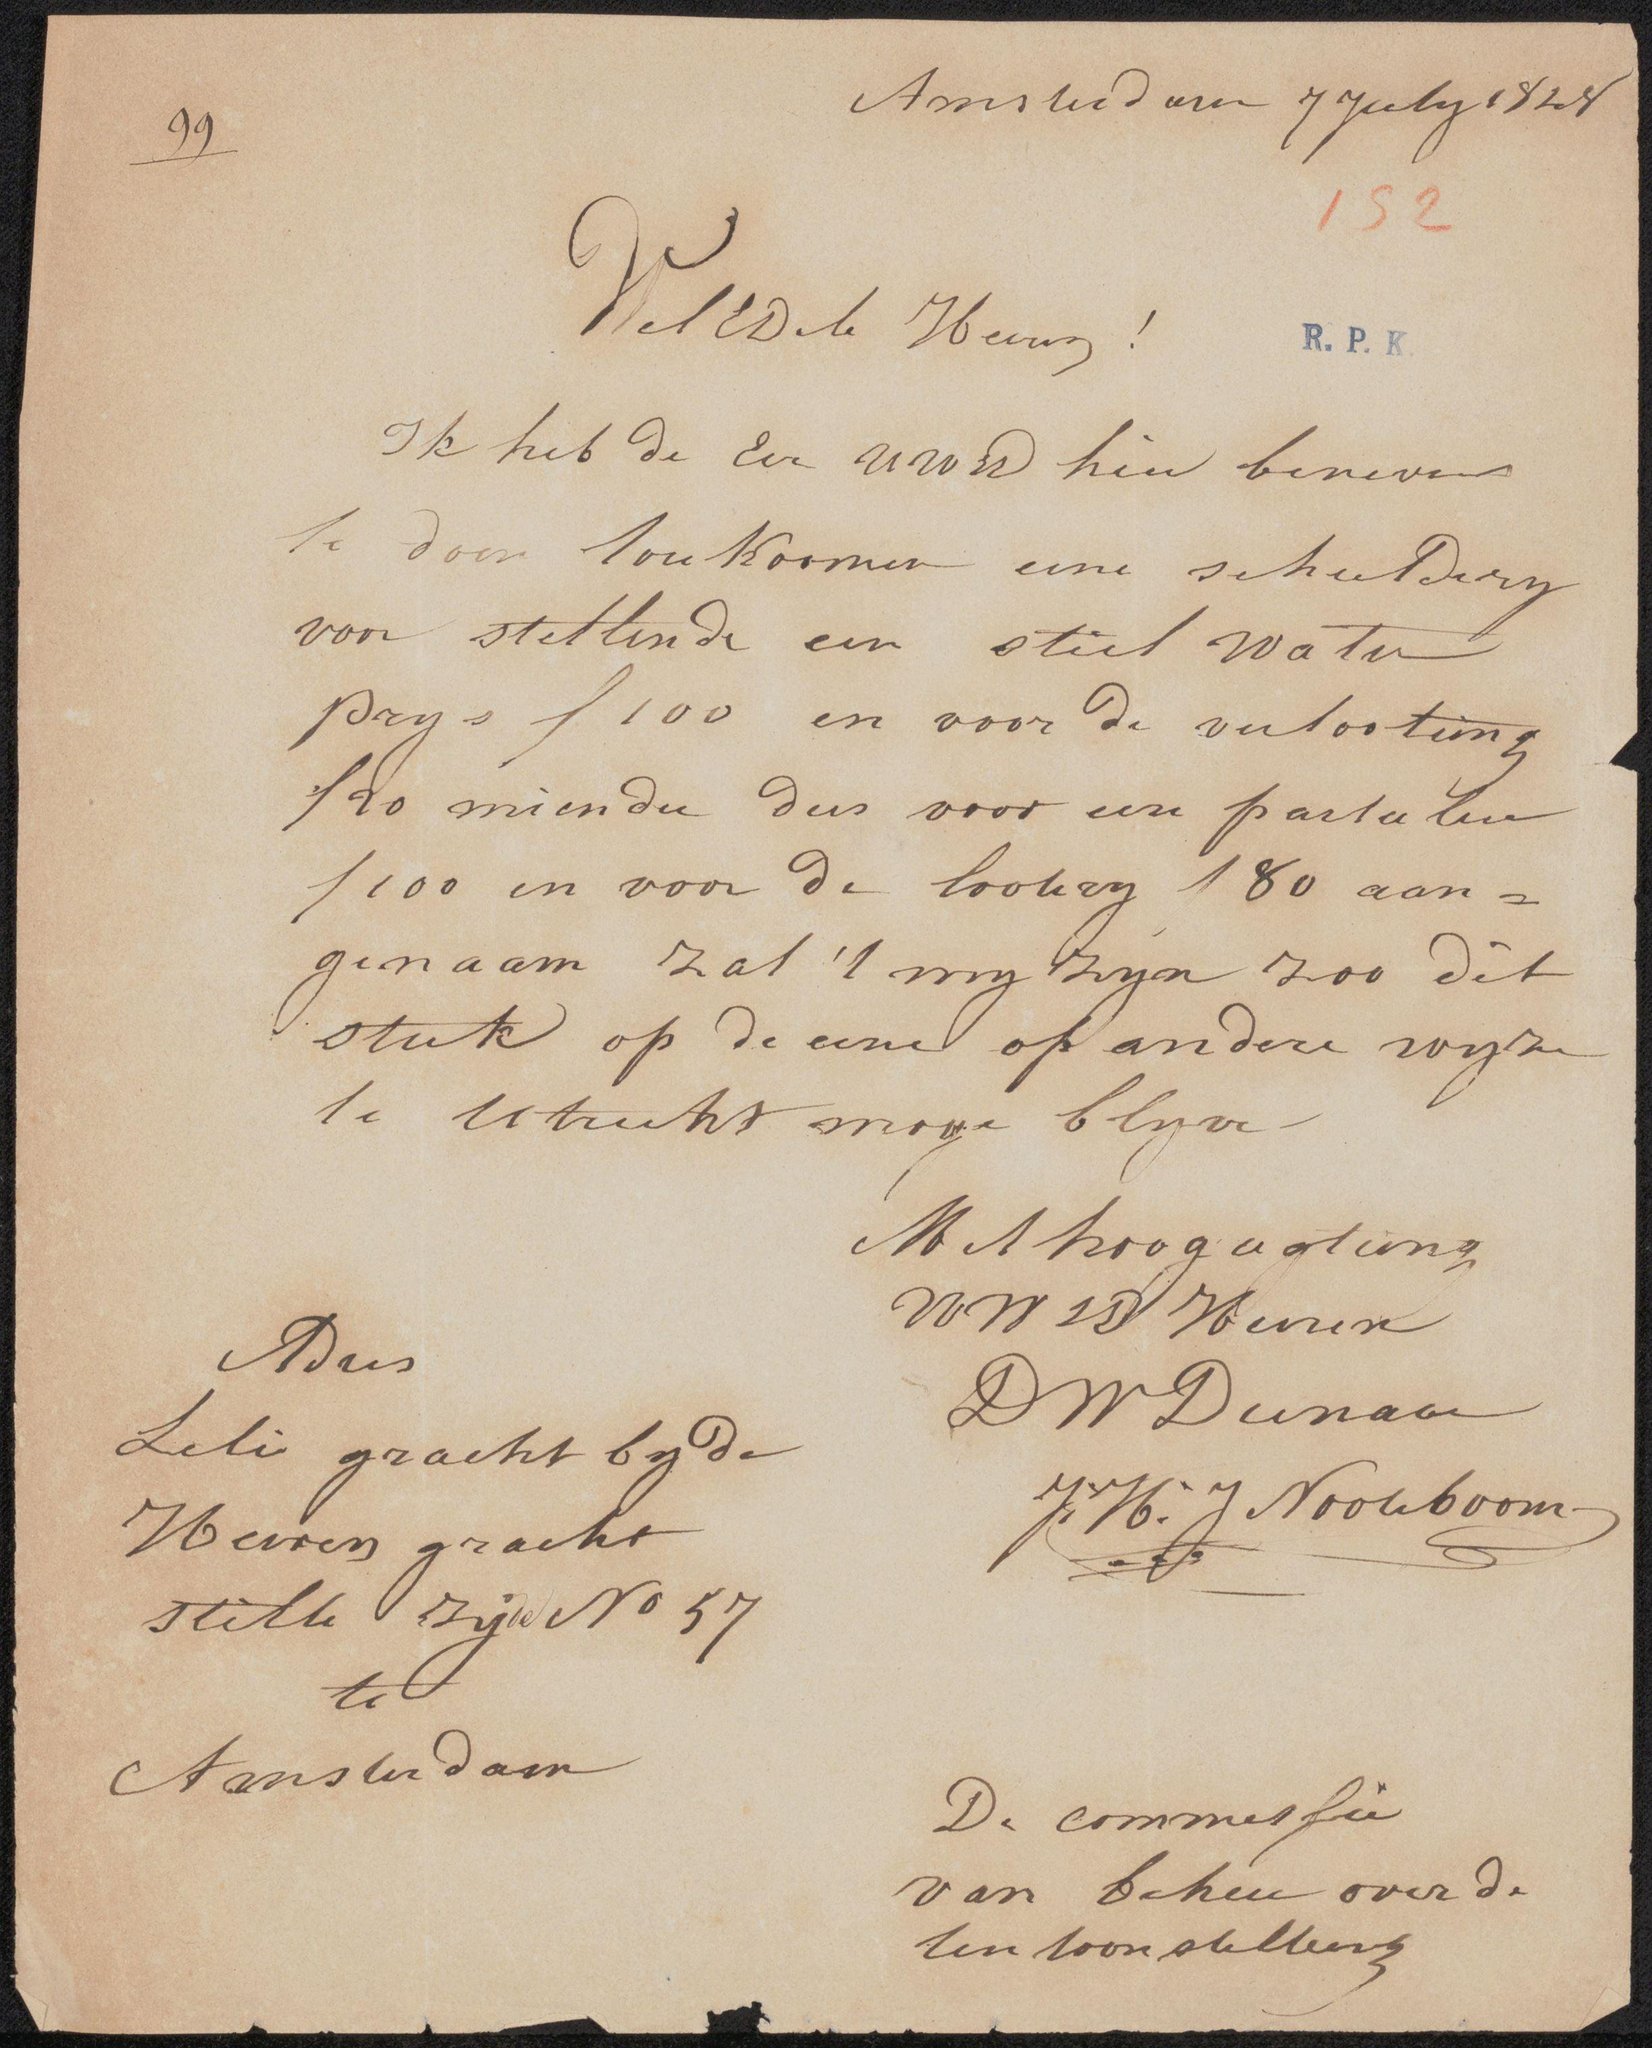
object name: letter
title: Brief aan de commissie van de Tentoonstelling van Levende Meesters in Utrecht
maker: jacobus hendricus johannes nooteboom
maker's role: draughtsman, painter, sculptor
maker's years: 1811-1878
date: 1848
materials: ink, paper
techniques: pen, writing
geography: amsterdam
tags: painting (including book-illumination, miniature-painting), exhibition ~ art, money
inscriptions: collector's mark: Lugt 2233